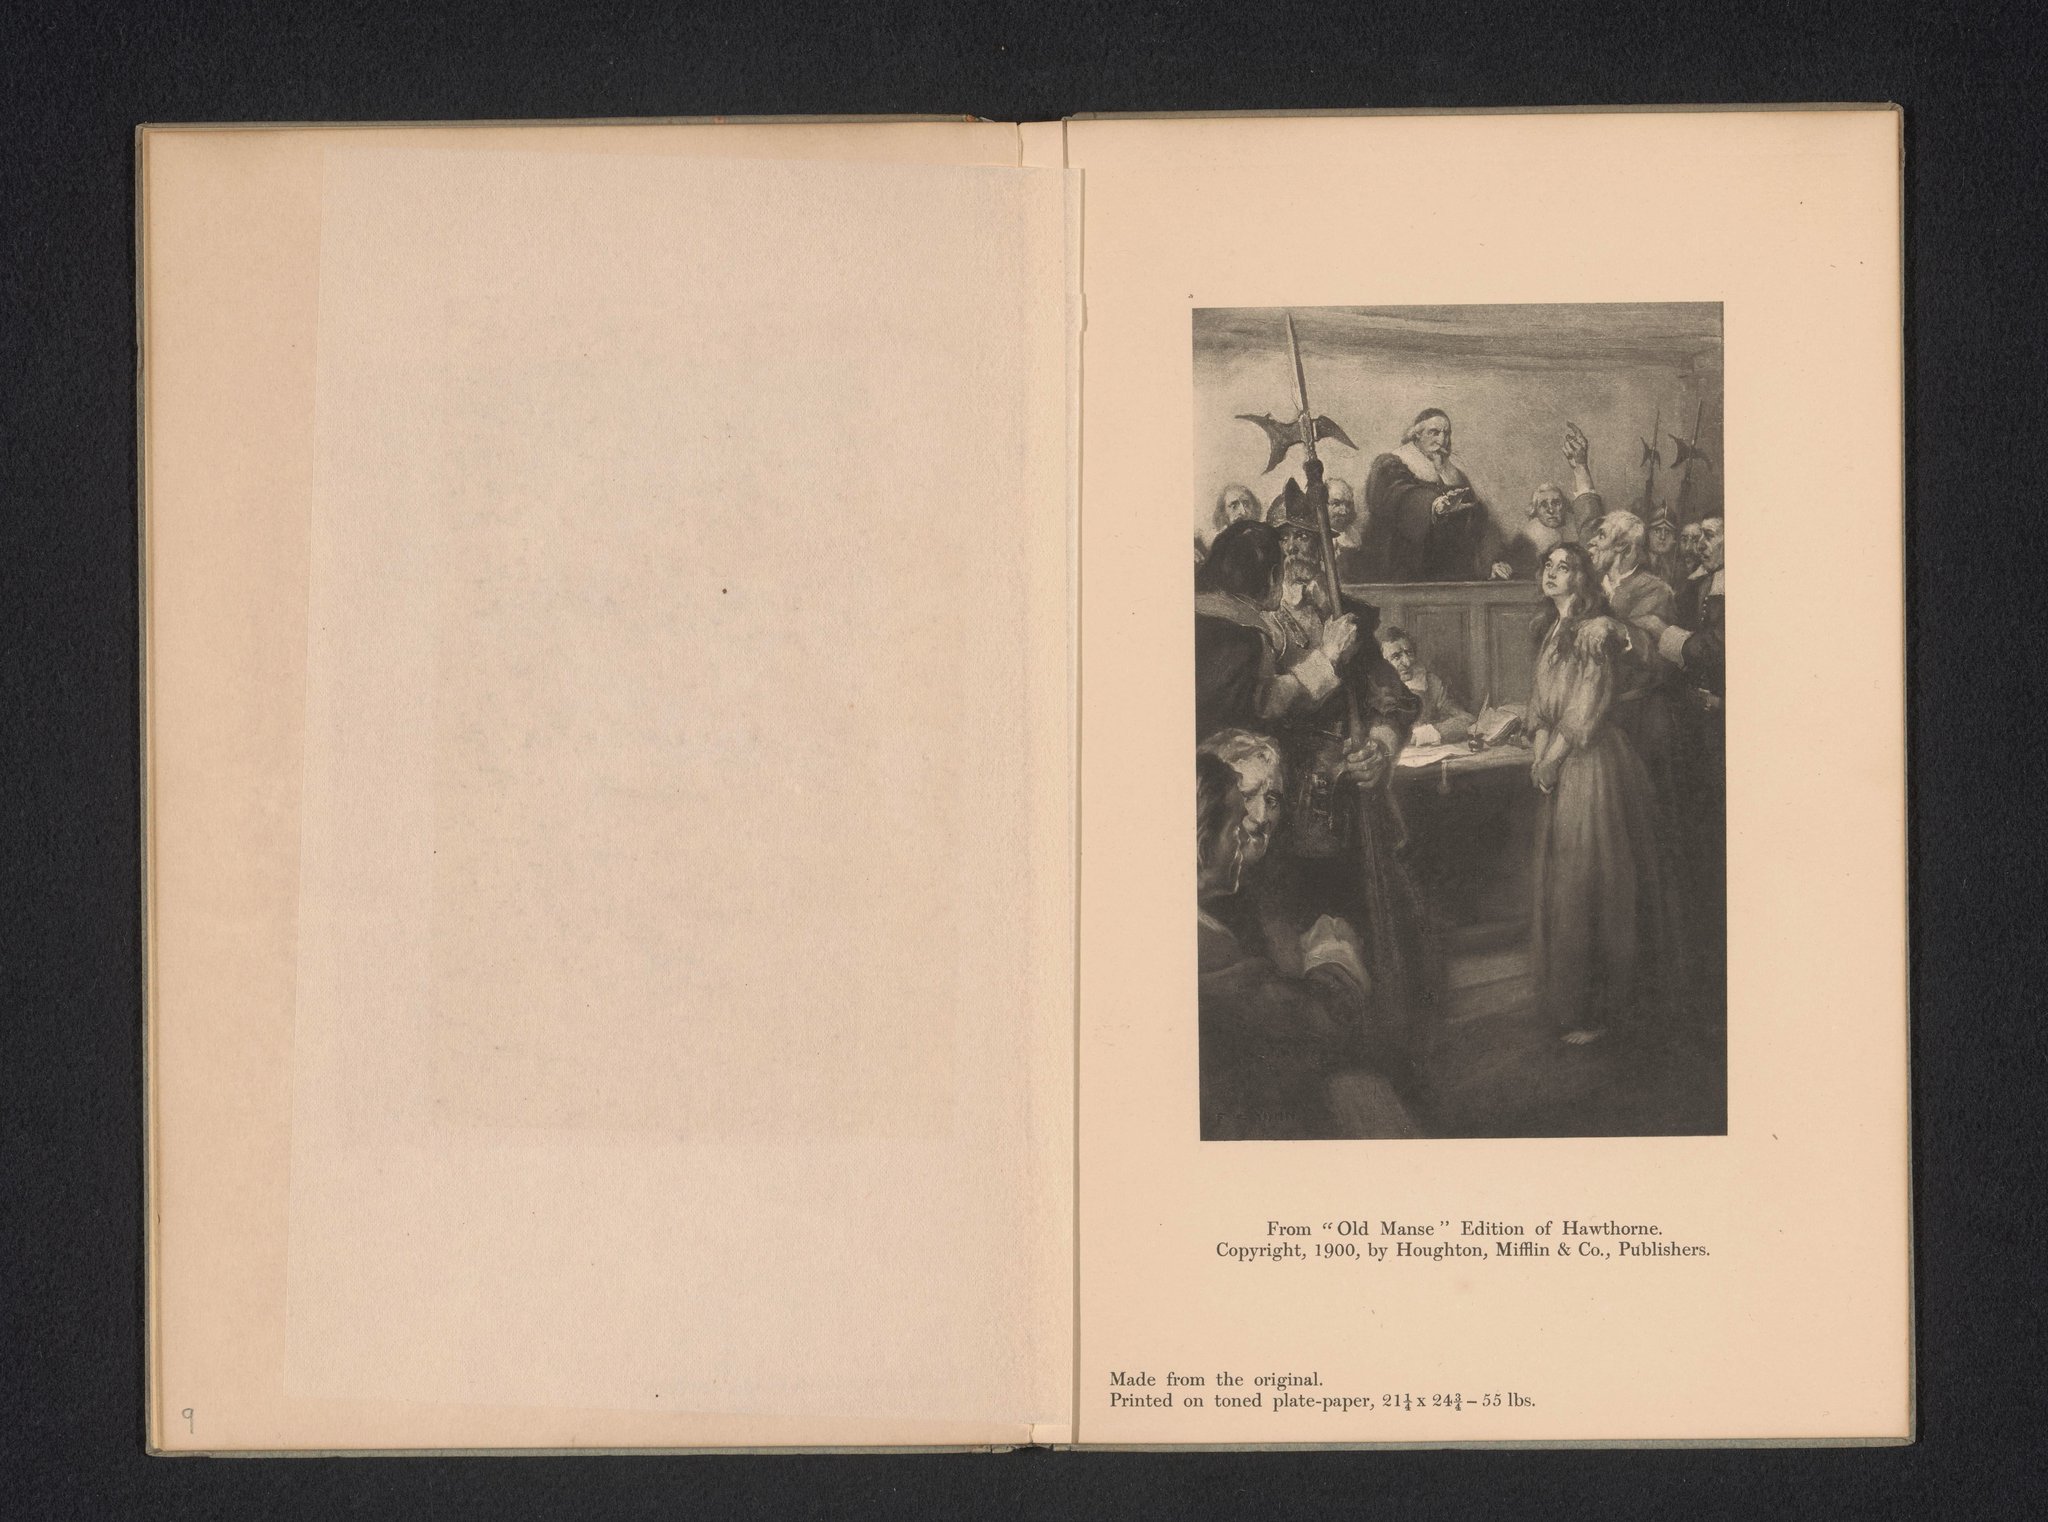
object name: page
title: Reproductie van een ontwerp van een vrouw die terecht staat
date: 1903-1908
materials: paper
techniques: photograph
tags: judicial verdict, court session (court of justice)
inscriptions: inscription: ‘From "Old Manse" Edition of Hawthorne./ Copyright, 1900, by Houghton, Mifflin & Co., Publishers./ Made from the original./ Printed on toned plate-paper (...)’